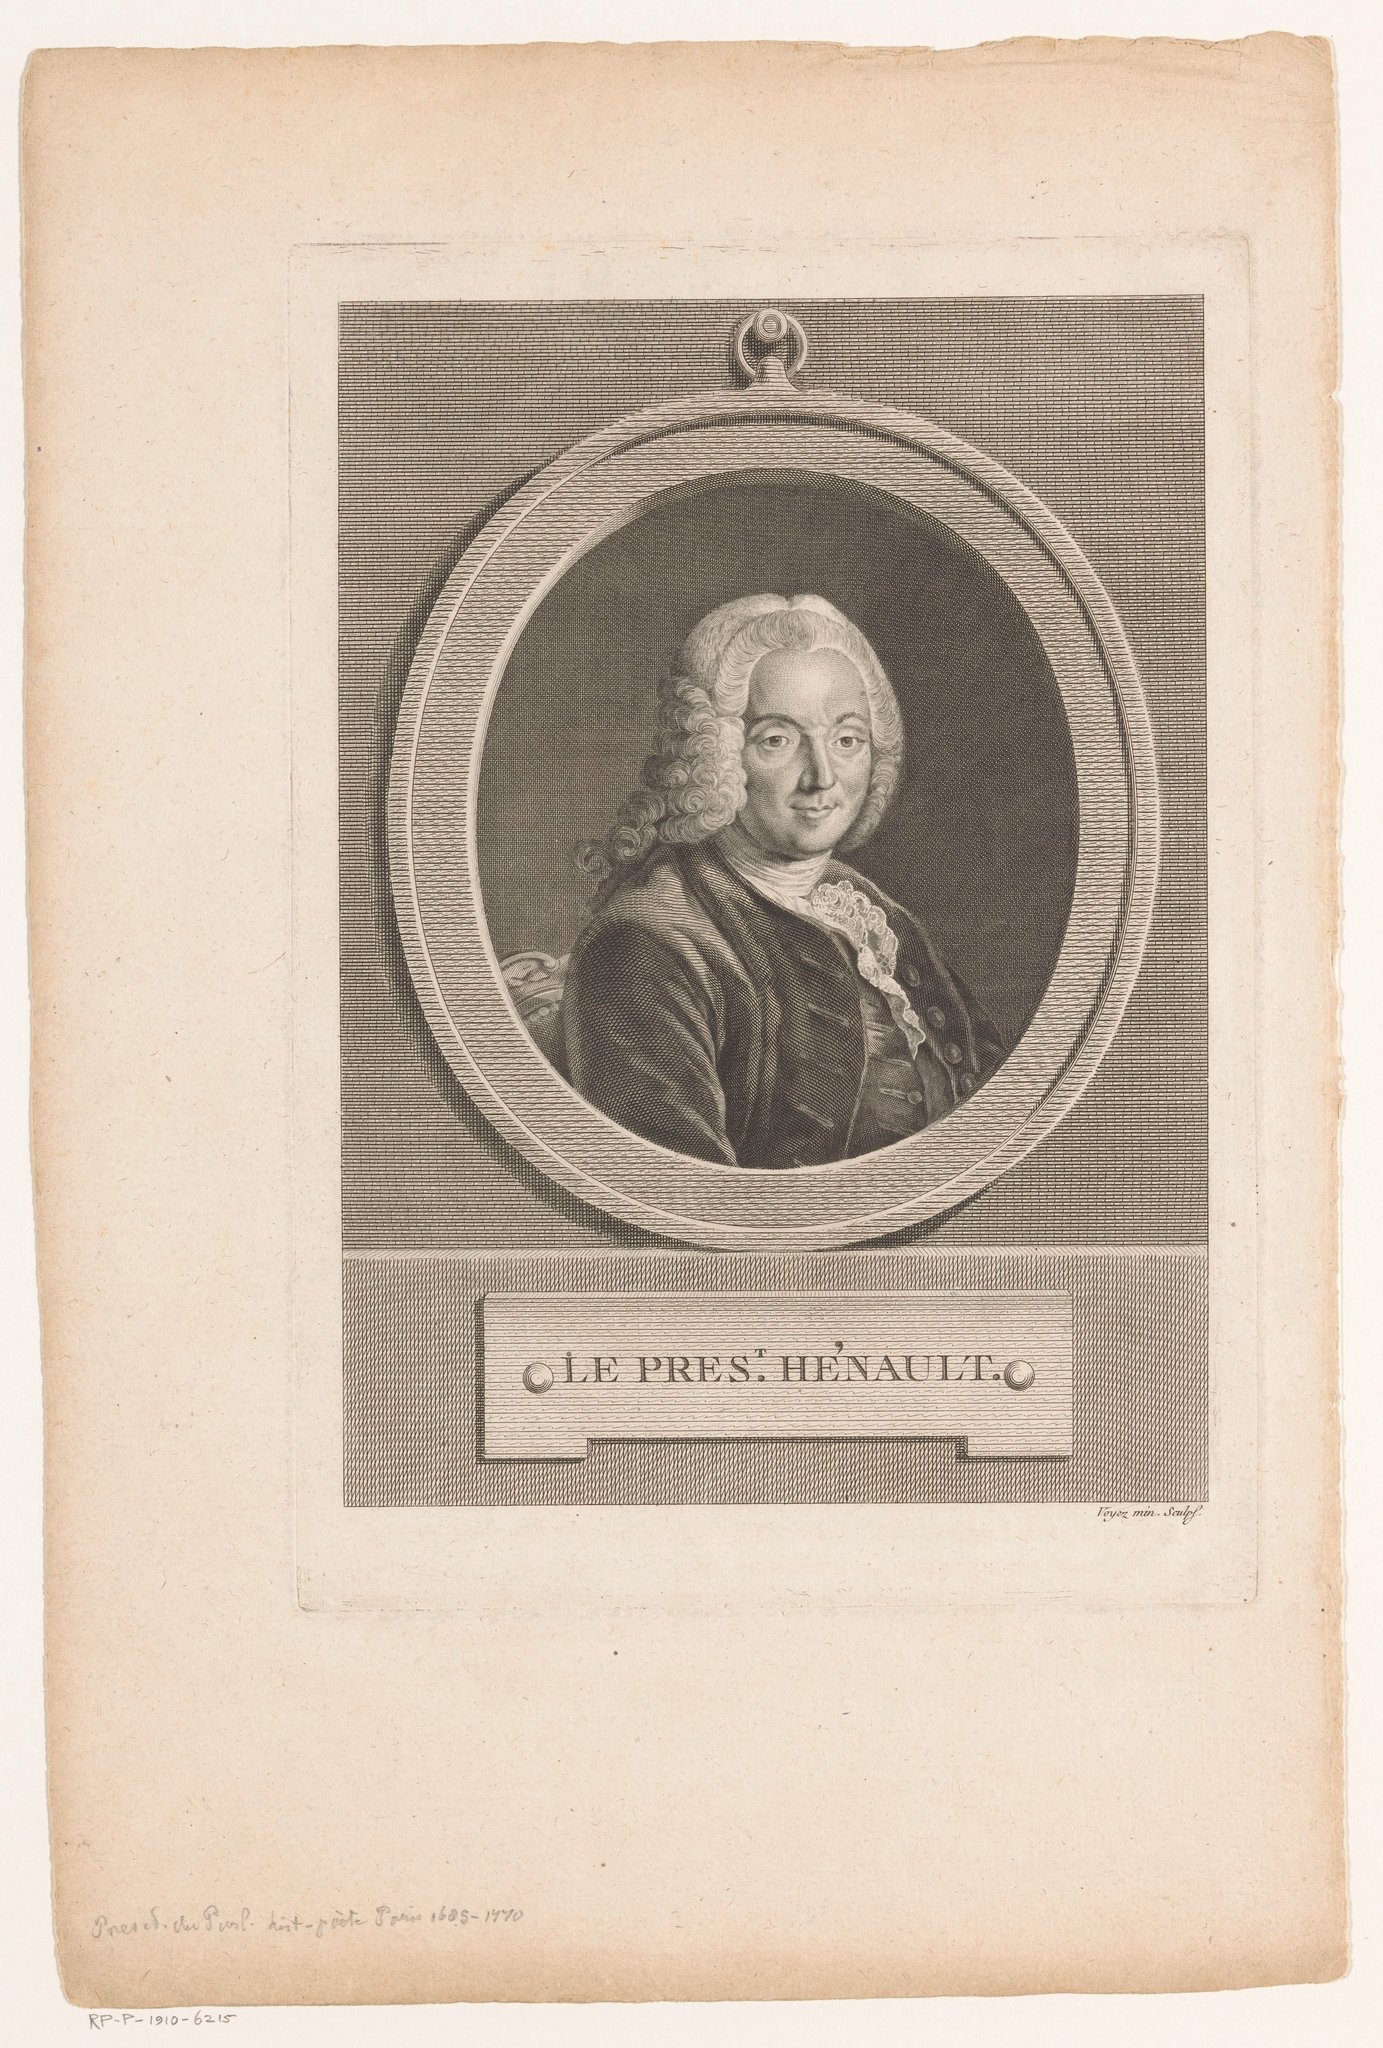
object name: print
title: Le Pres.t Hénault.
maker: françois voyez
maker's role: print maker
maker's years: 1746-1805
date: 1756-1805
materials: paper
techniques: engraving, etching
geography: france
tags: paris, historical persons, writer, poet, author, wig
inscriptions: collector's mark: Lugt 2228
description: Buste van Charles-Jean-François Hénault in een medaillon.